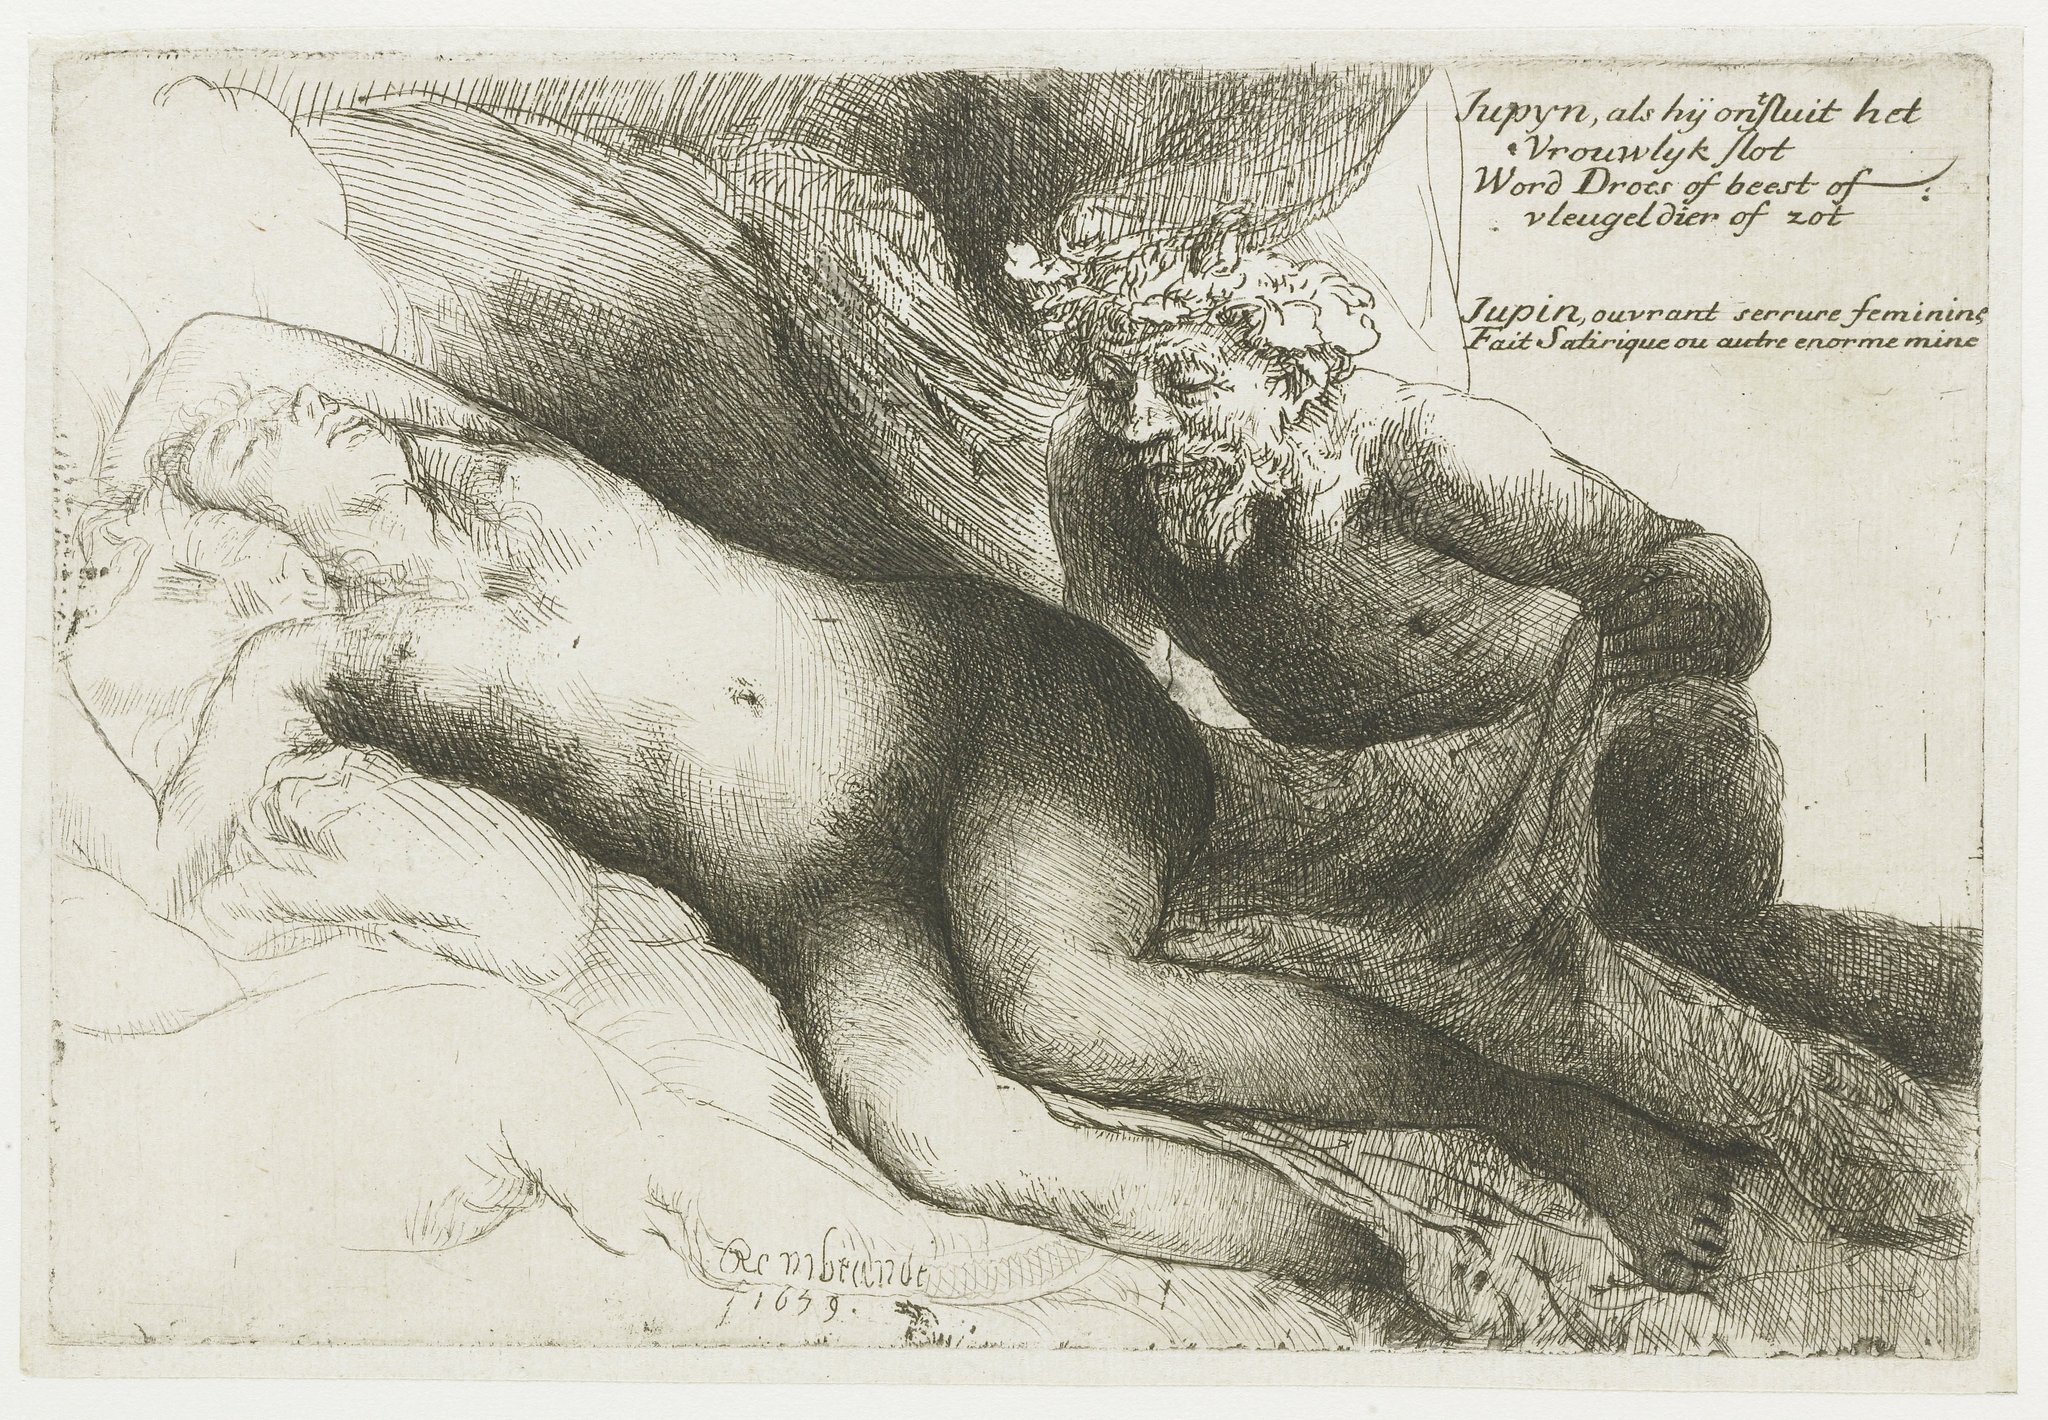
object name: print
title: Jupiter and Antiope: the larger plate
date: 1659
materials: paper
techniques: drypoint, etching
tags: jupiter, disguised as a satyr, approaches the sleeping antiope; the eagle may be standing nearby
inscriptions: inscription: ‘Jupin, ouvrant (...) enorme mine’ gedicht, signature and date: ‘Rembrandt f 1659’, inscription: ‘Jupyn, als hij (...) vleugeldier of zot’ gedicht, mark: Lugt 2228 a, mark: Lugt 2760